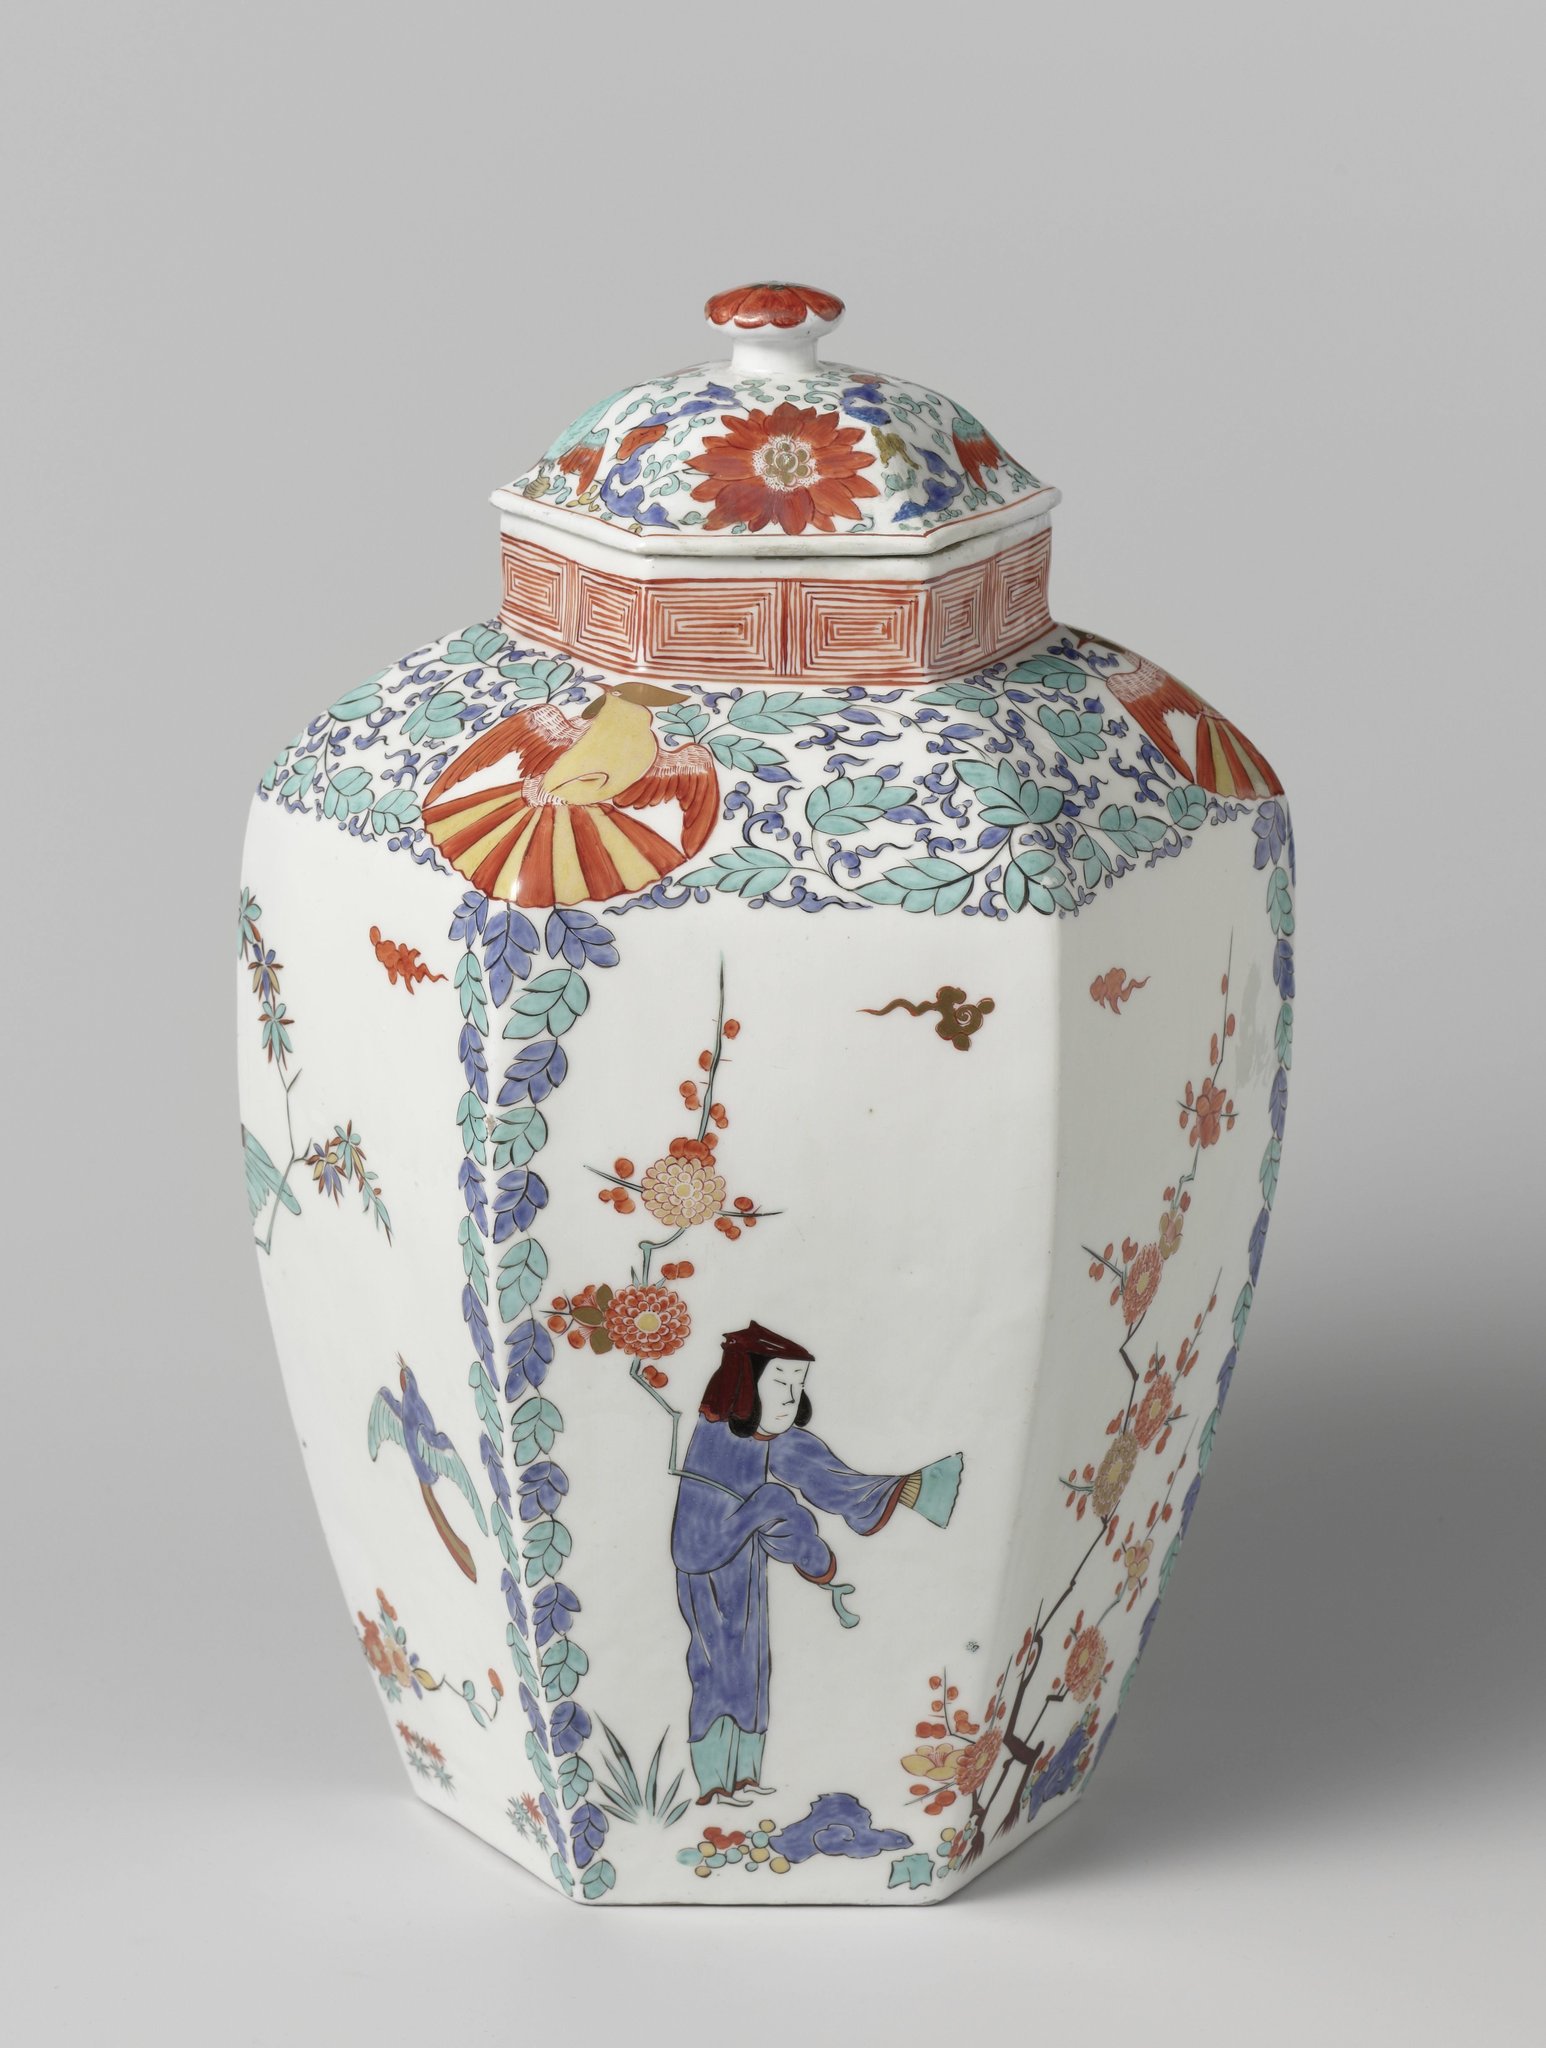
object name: decoratief object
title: Two lidded vases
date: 1725-1730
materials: porcelain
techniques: painted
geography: meissen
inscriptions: mark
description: Meissener Porzellan Manufaktur, Meissen, c. 1725–1730, hard-paste porcelain